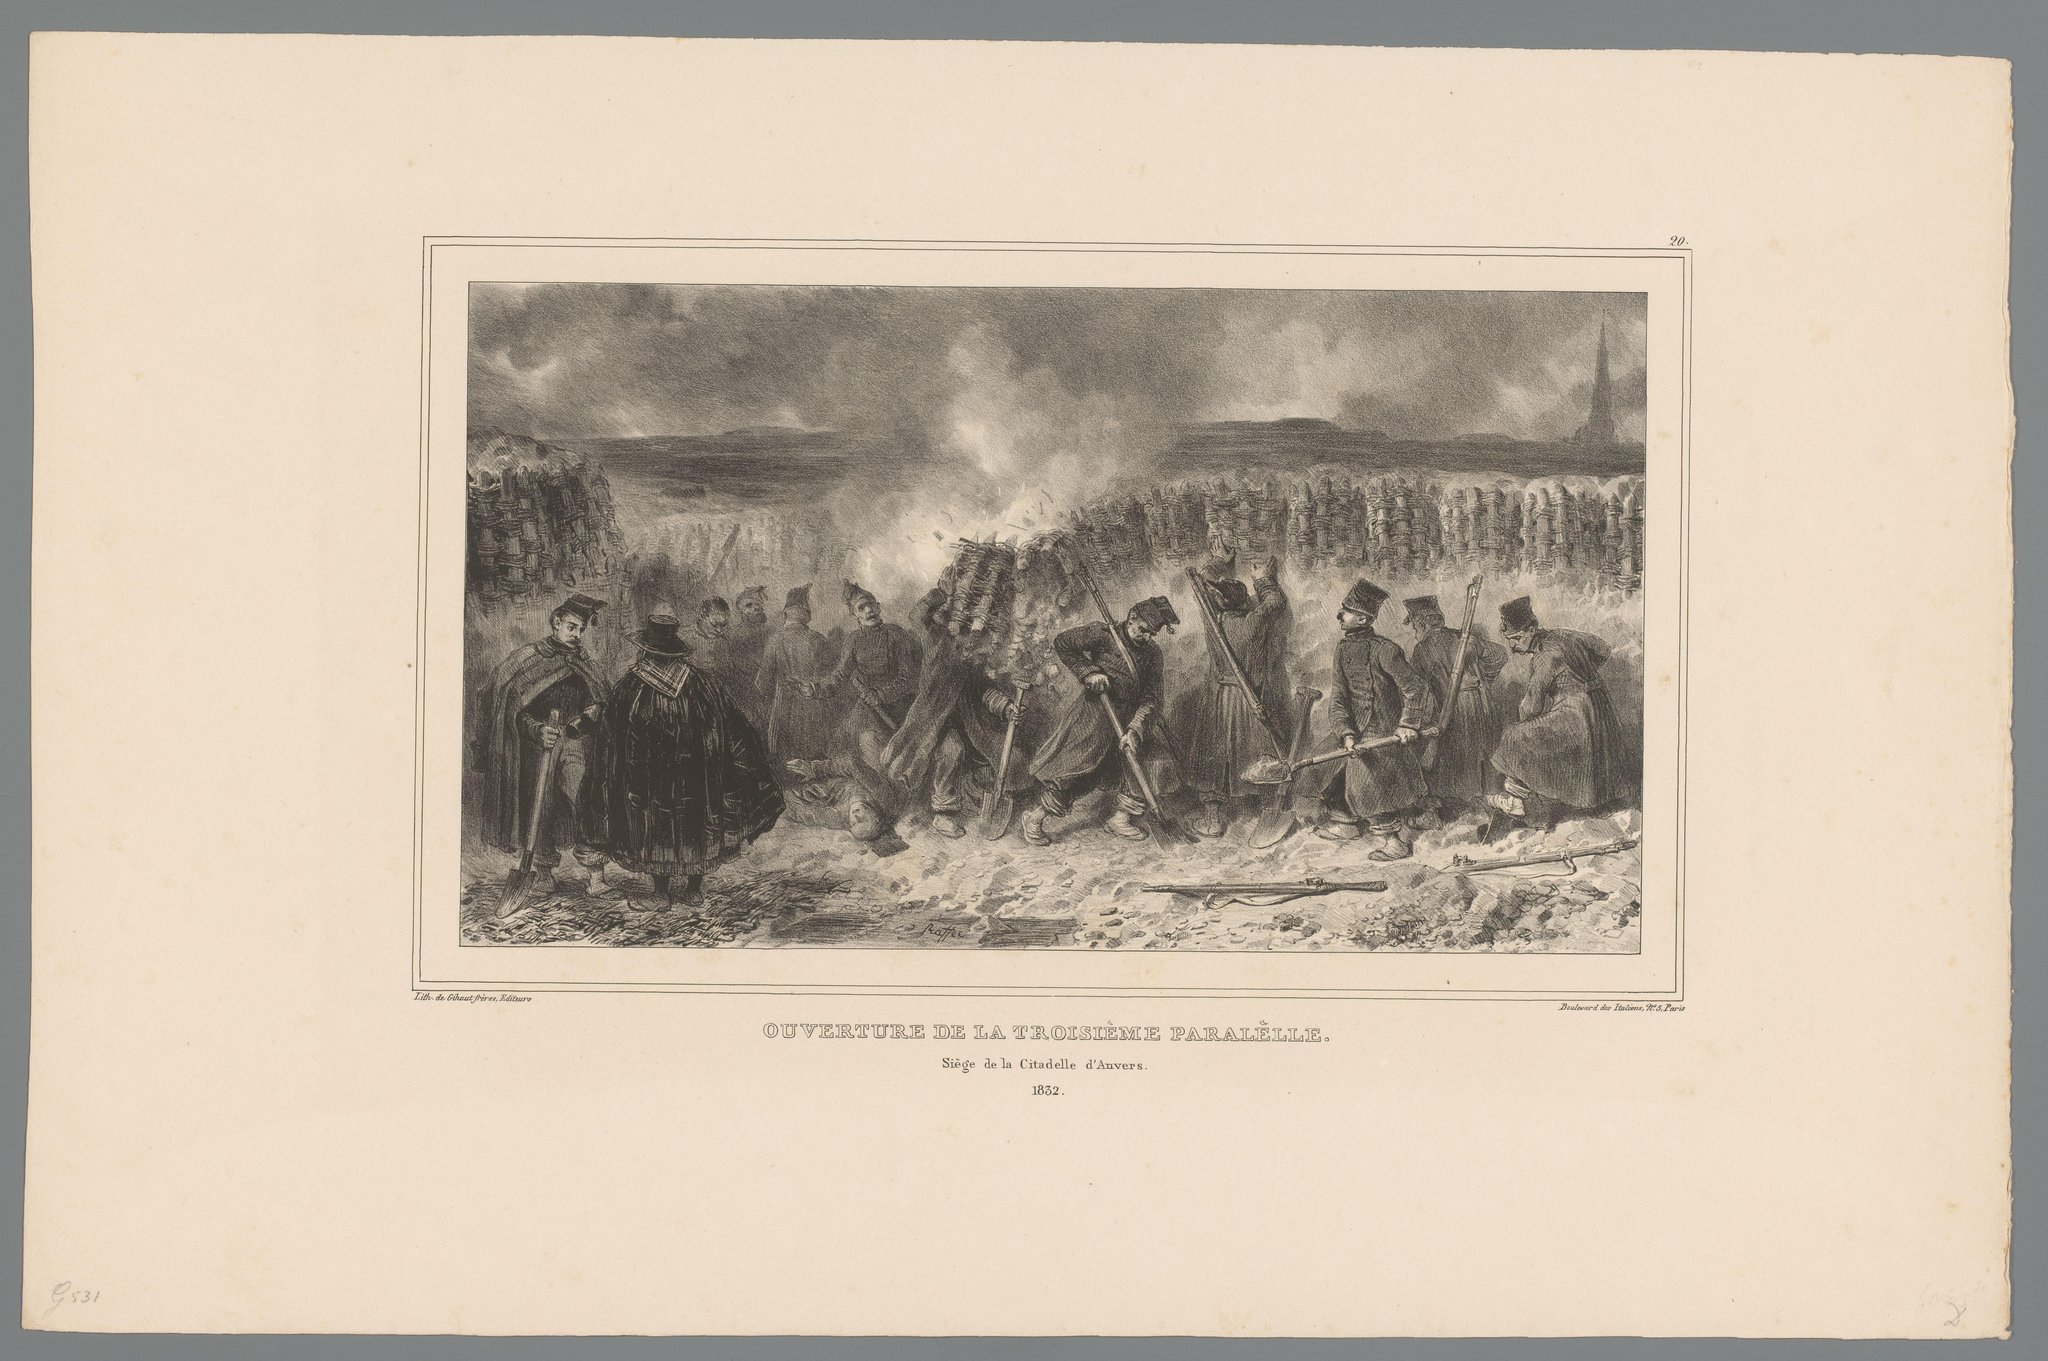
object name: print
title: Dessins faits d'après nature au siège de la Citadelle d'Anvers par Raffet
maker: denis auguste marie raffet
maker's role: draughtsman, print maker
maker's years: 1804-1860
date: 1833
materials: paper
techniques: lithograph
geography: paris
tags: siege, position war, palissade, the soldier; the soldier's life, temporary fortifications, trenches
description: Soldaten graven een loopgraaf achter een palissade. Rechts op de achtergrond een kerktoren. Onderdeel van de serie van 24 prenten over het beleg van de Citadel van Antwerpen, 30 november - 23 december 1832.